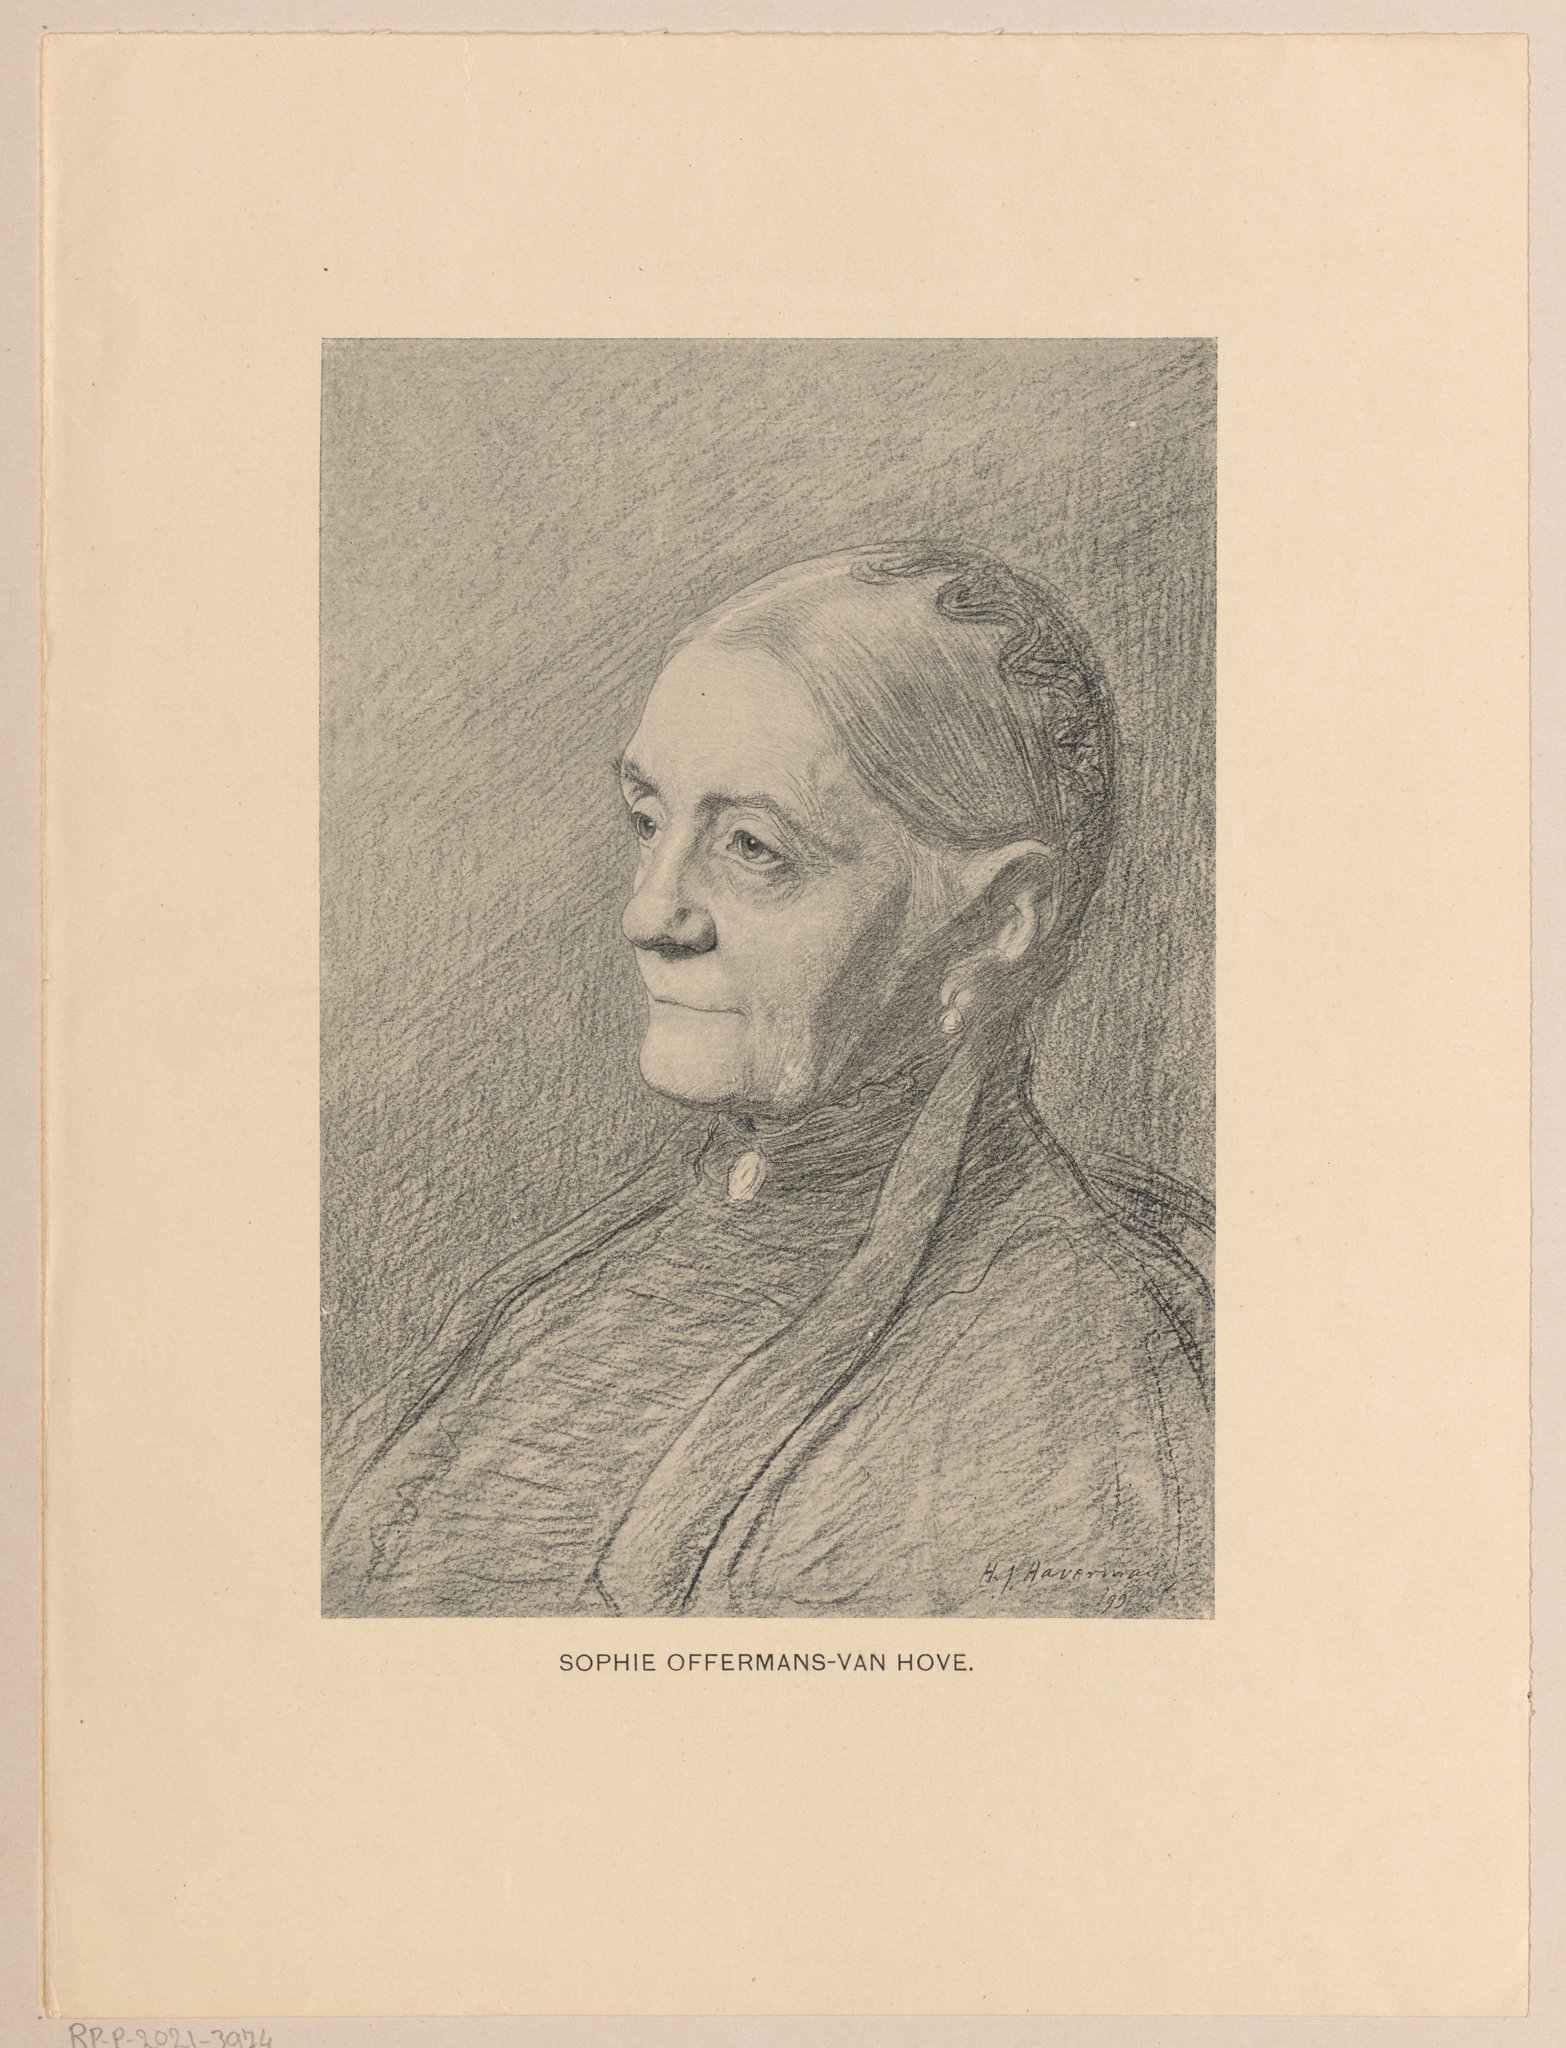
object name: photomechanical print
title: Portret van Sophia Johanna Huiberta van Hove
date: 1899-1970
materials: paper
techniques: letterpress printing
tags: historical persons - bb - woman